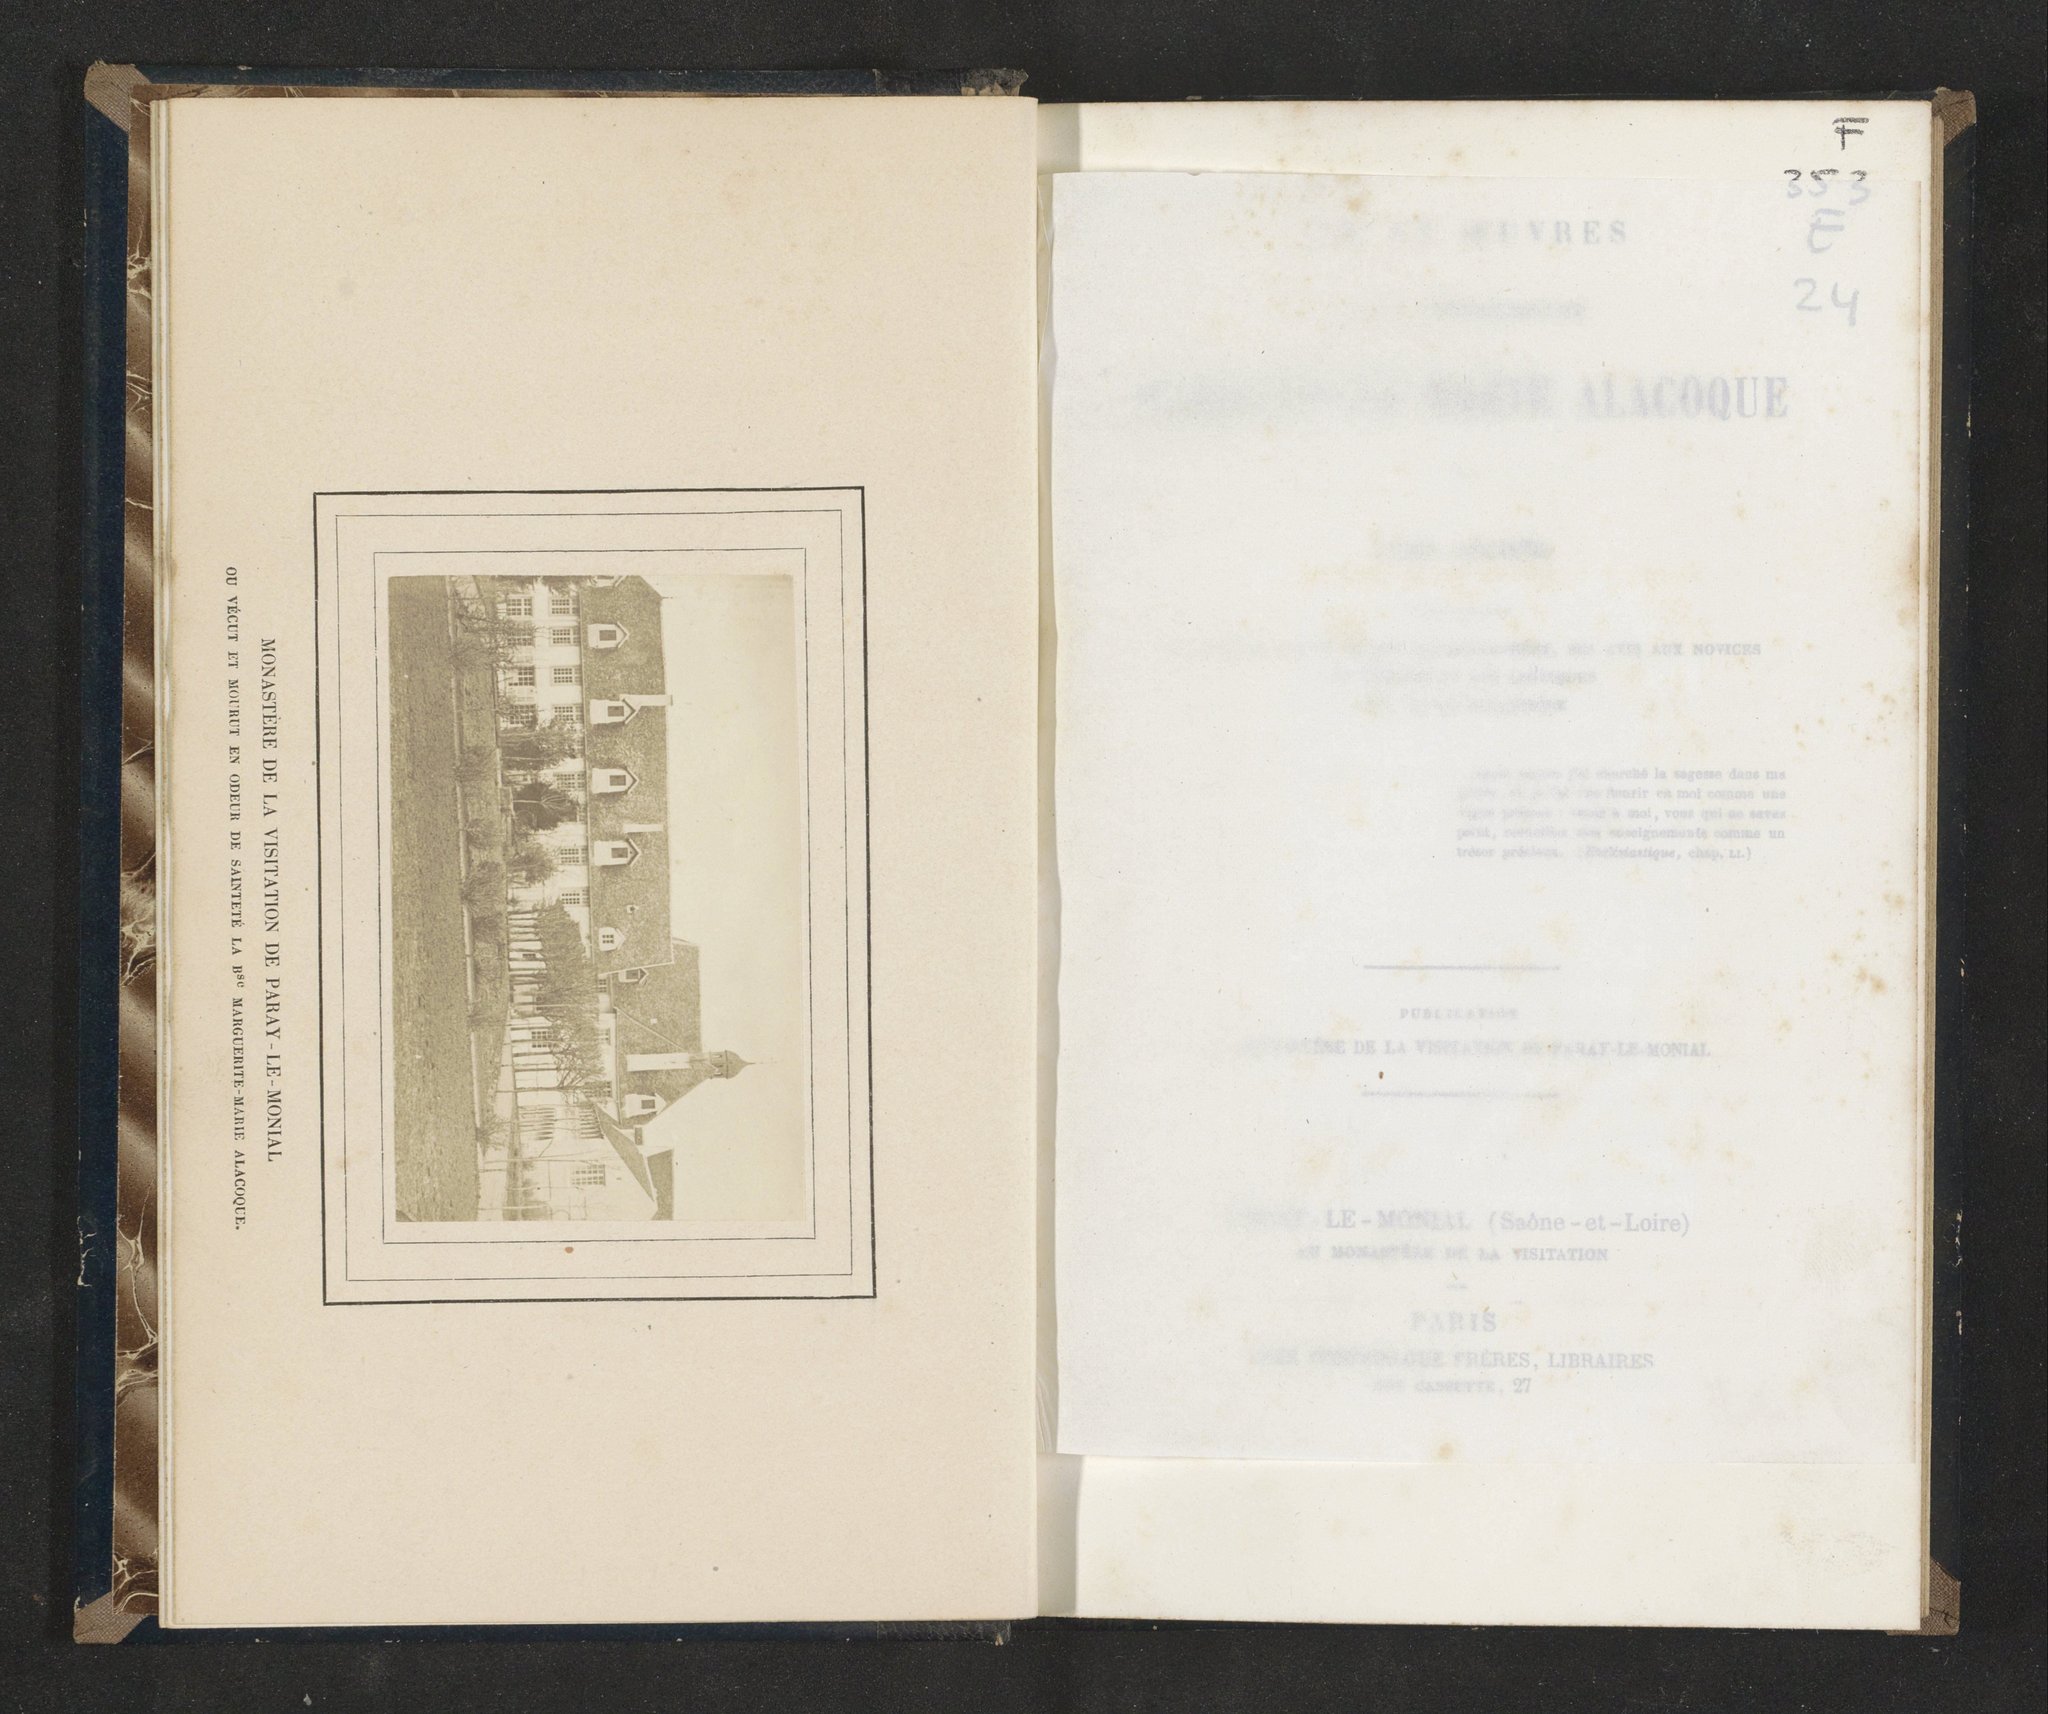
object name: page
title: Monastère de la Visitation de Paray-le-Monial ou vécut et mourut en odeur de sainteté la Bse Marguerite-Marie Alacoque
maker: Anonymous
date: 1857-1867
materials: photographic support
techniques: albumen print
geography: paray-le-monial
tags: cloisters ~ monastery